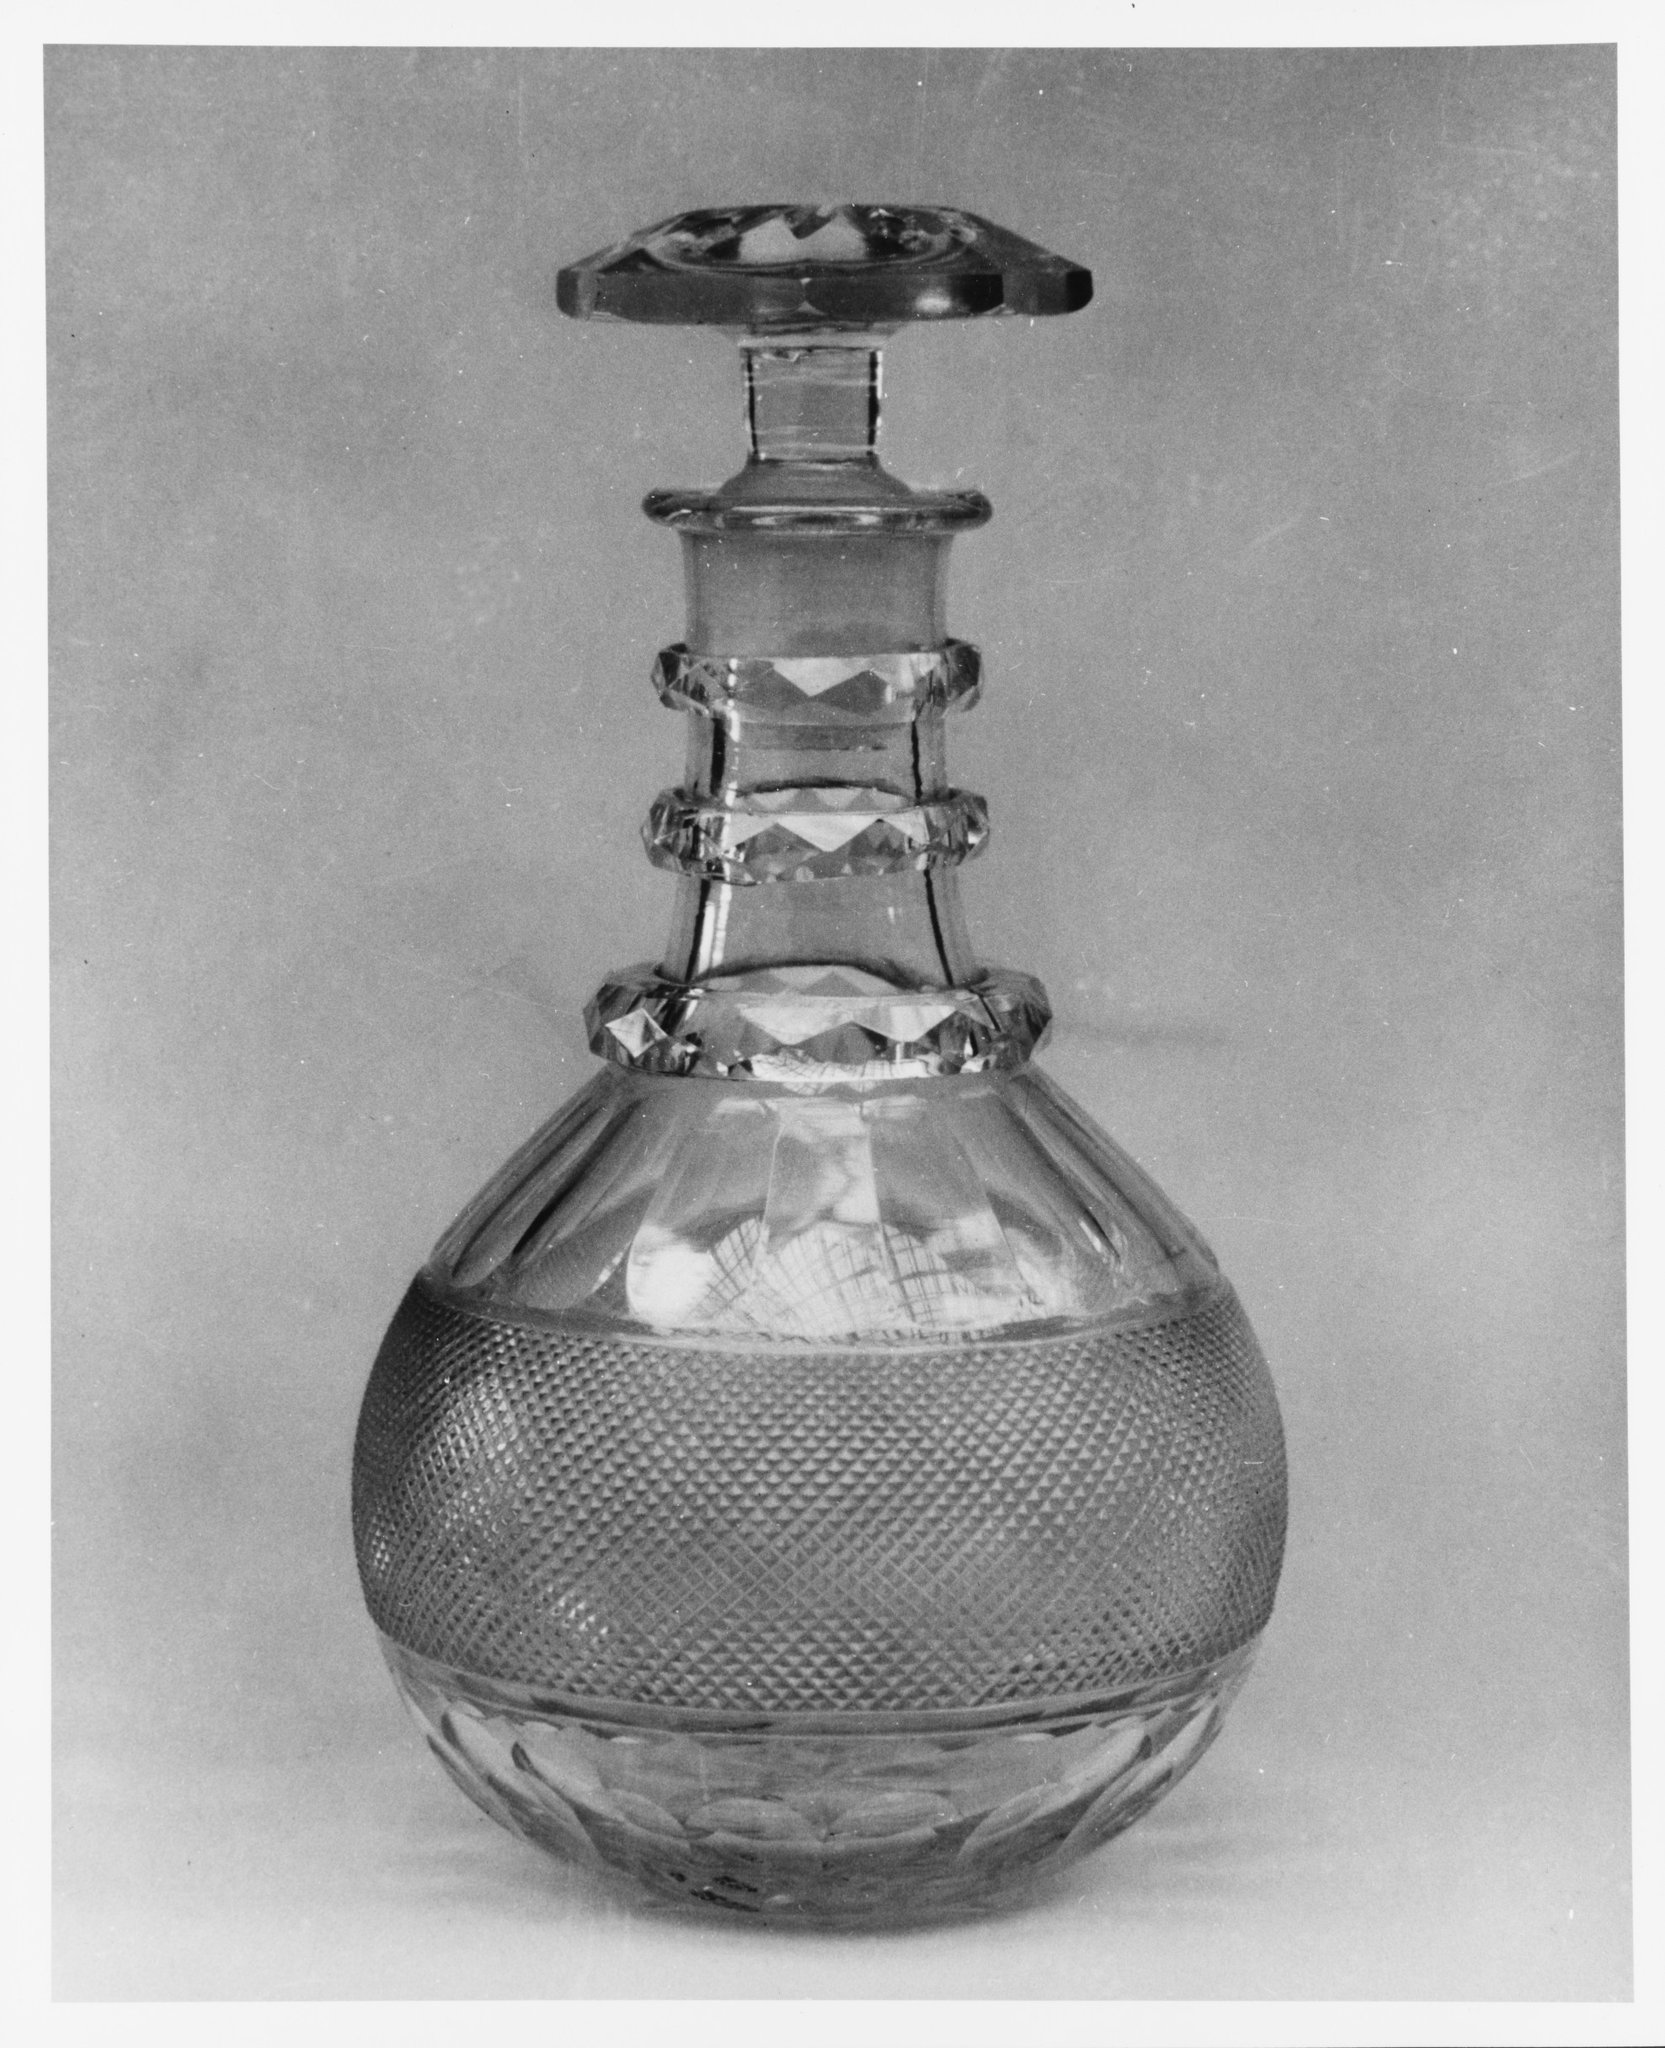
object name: brandy decanter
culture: british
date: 1801-1900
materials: glass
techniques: glassblowing, cutting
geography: england